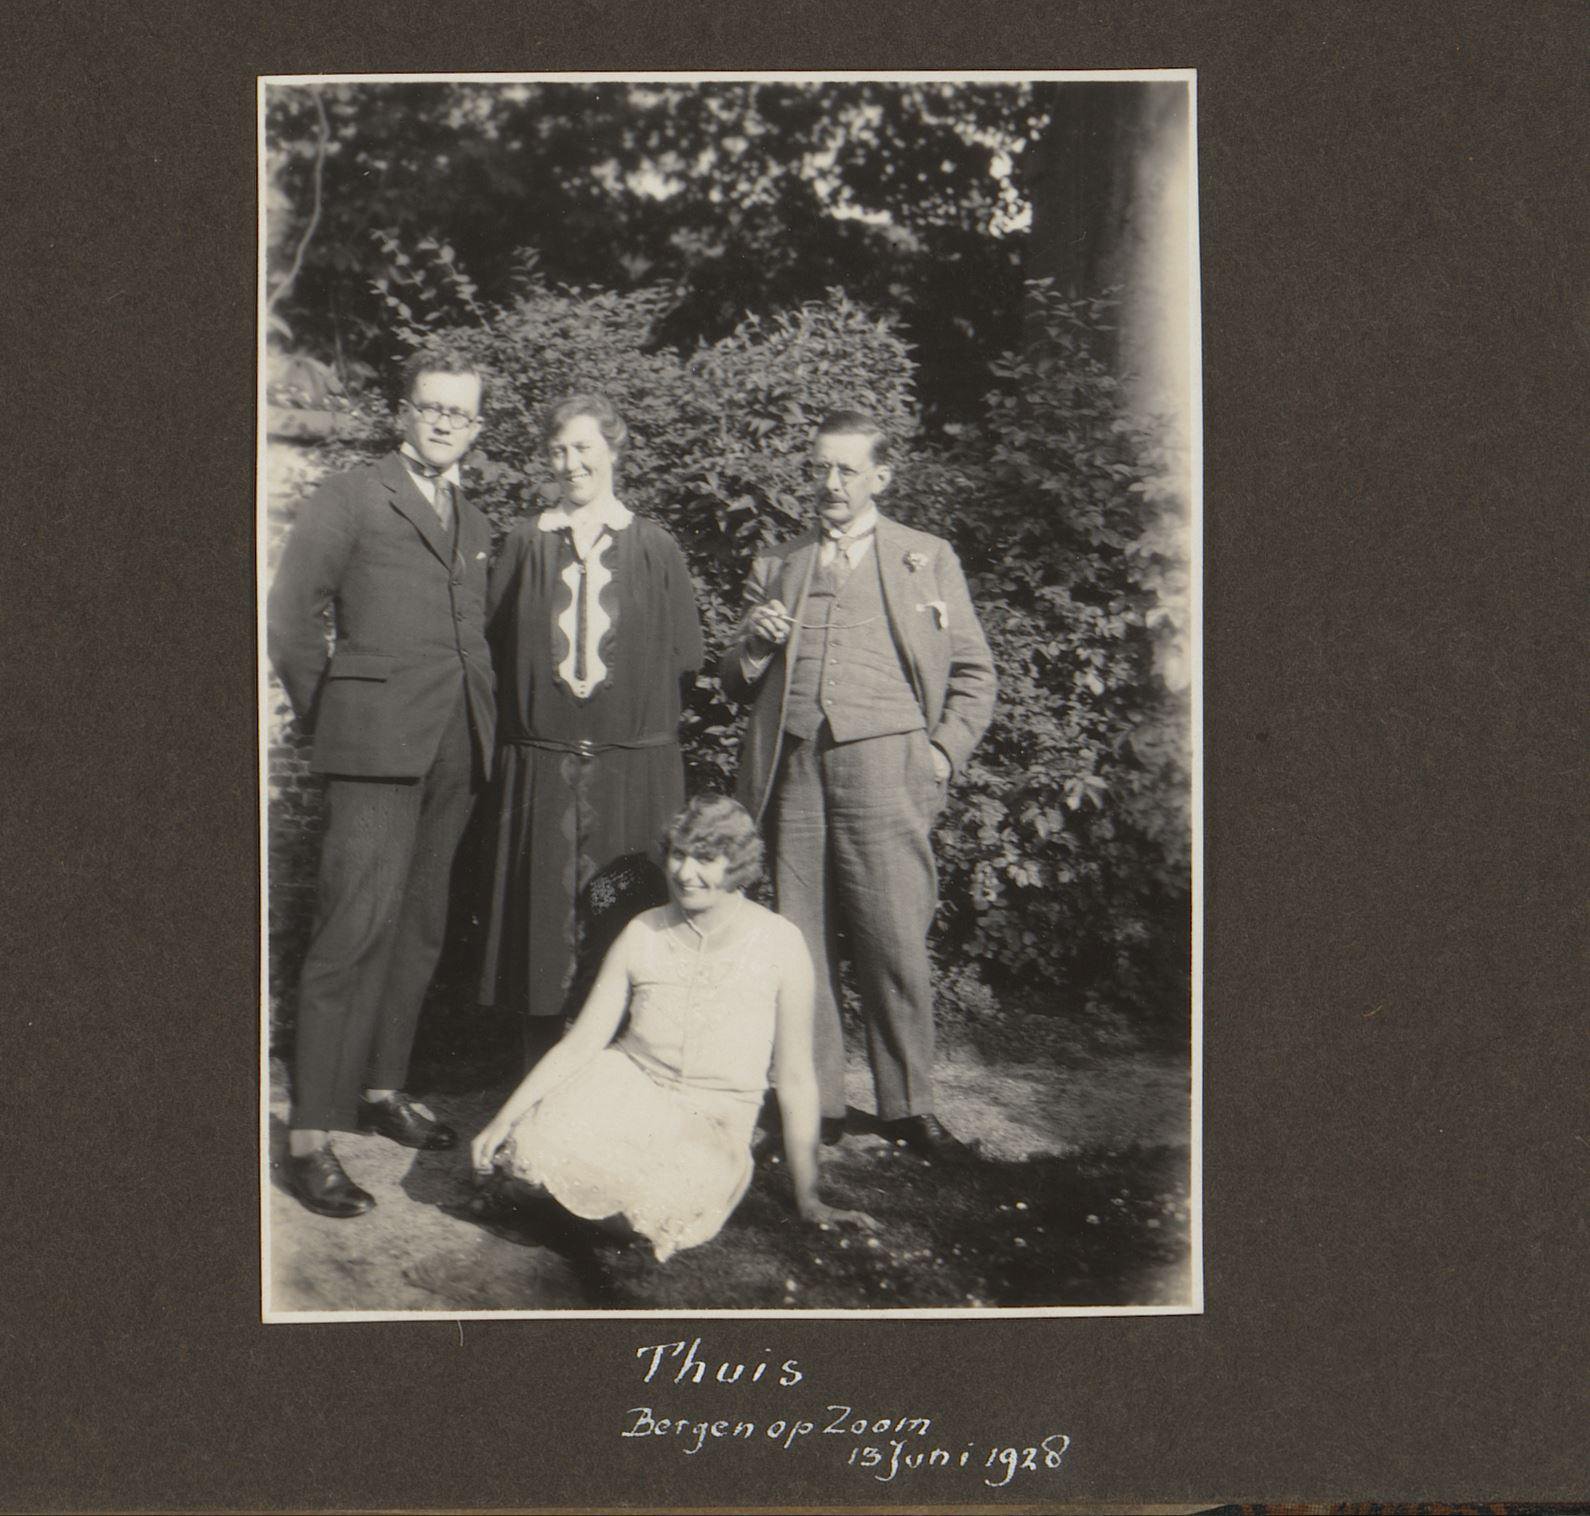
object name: photograph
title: Portret van een onbekend gezin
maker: Anonymous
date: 1928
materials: photographic support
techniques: gelatin silver print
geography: bergen op zoom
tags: adult woman, parents with their children, adult man, historical persons, bergen op zoom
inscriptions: annotation: ‘Thuis/ Bergen op Zoom/ 13 Juni 1928’